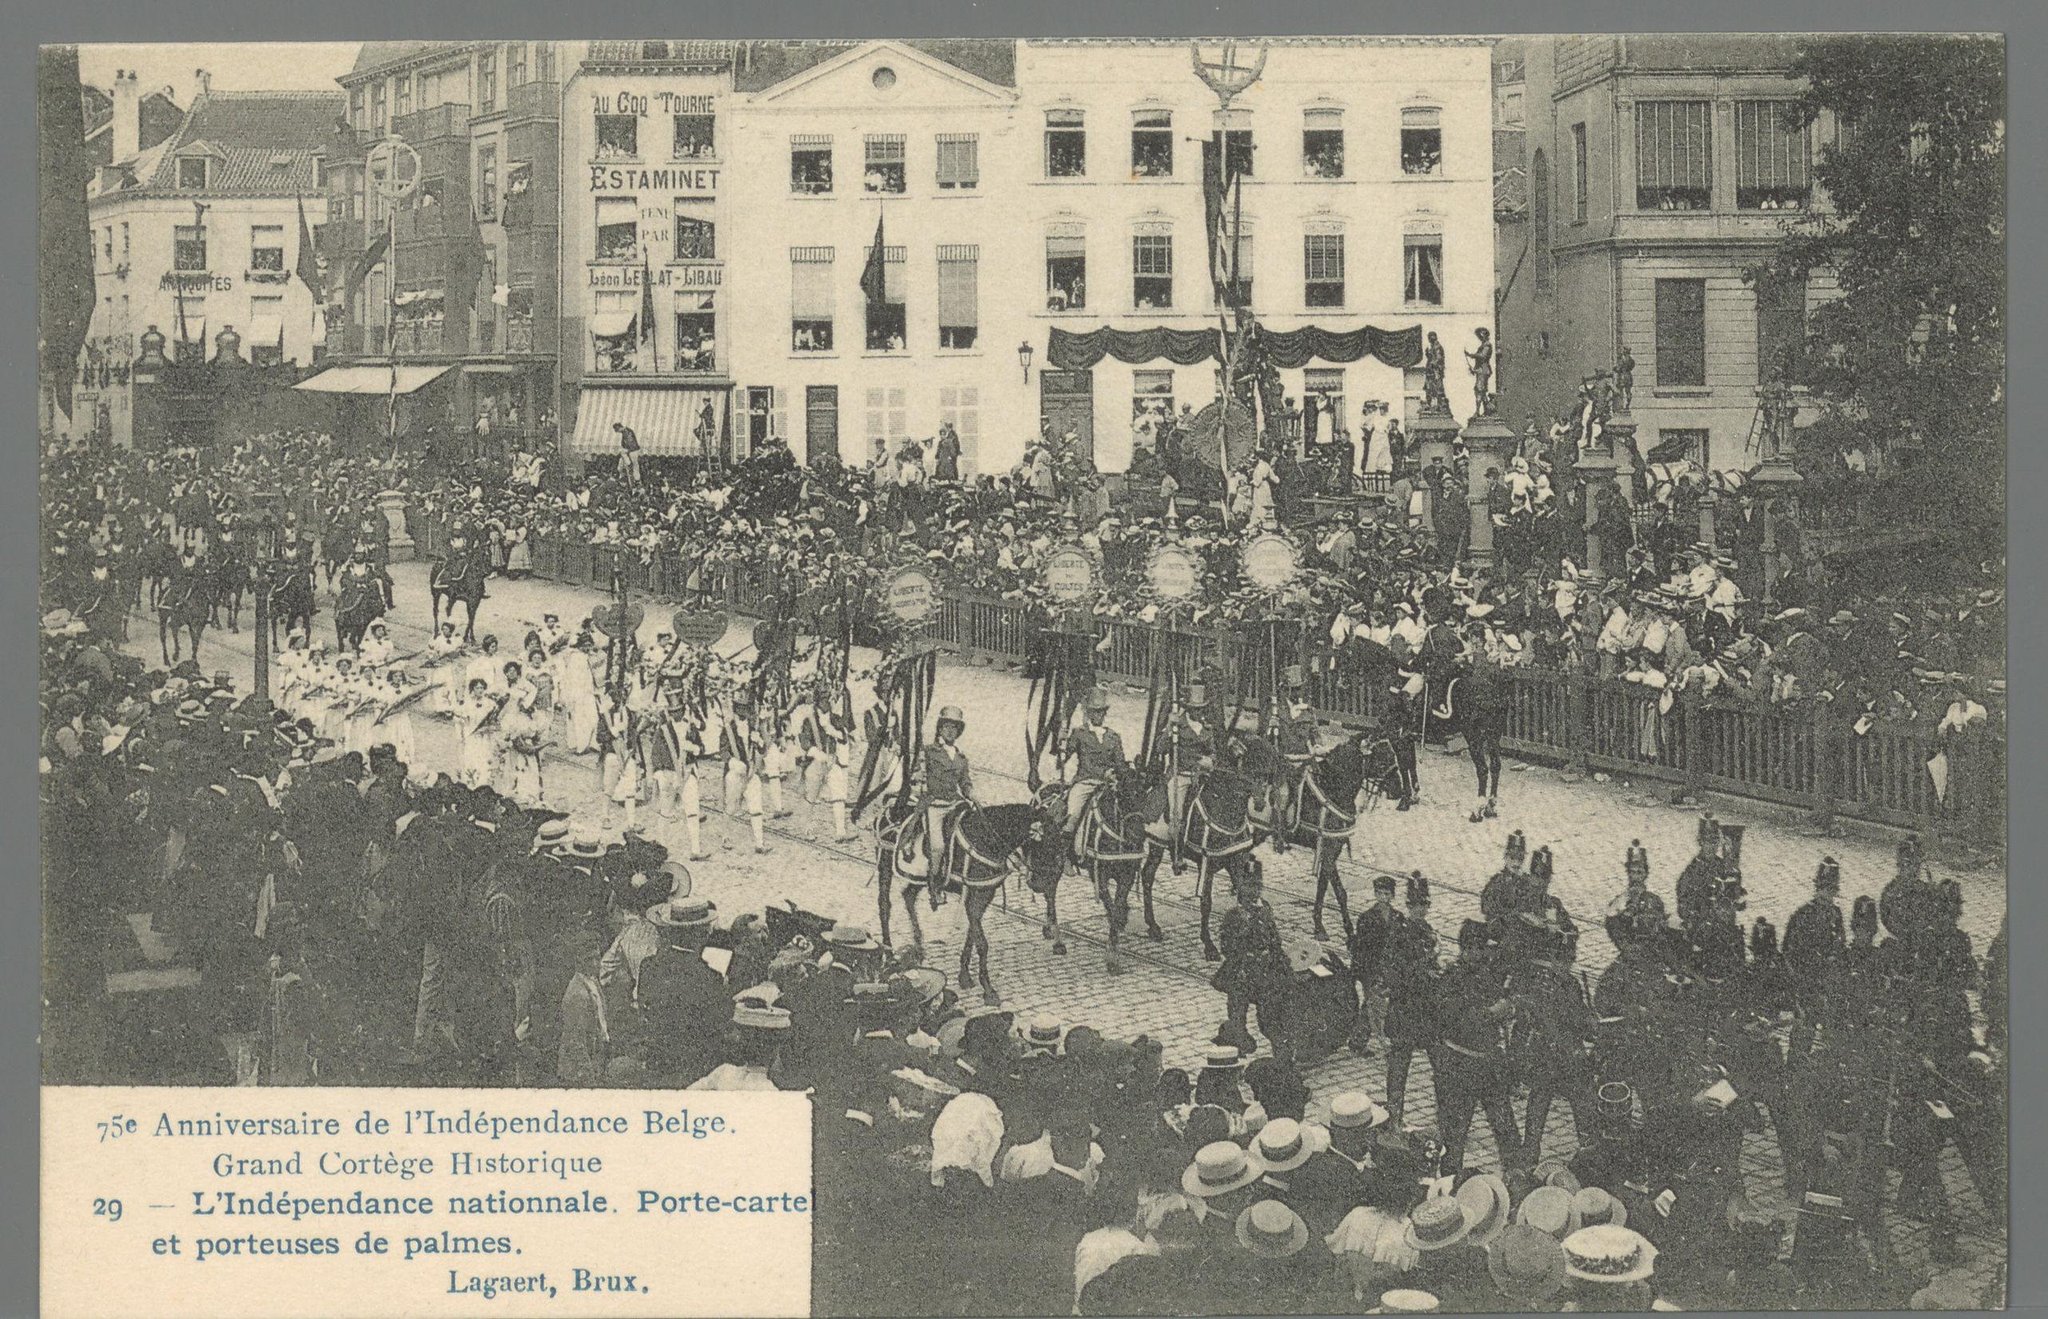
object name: ansichtkaart, prentbriefkaart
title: L'Indépendance nationale. Porte-cartel et porteuses de palmes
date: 1905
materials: cardboard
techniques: photograph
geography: brussels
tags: city-view, and landscape with man-made constructions (+ city(-scape) with figures, staffage), periodic celebrations, popular feasts, brussels